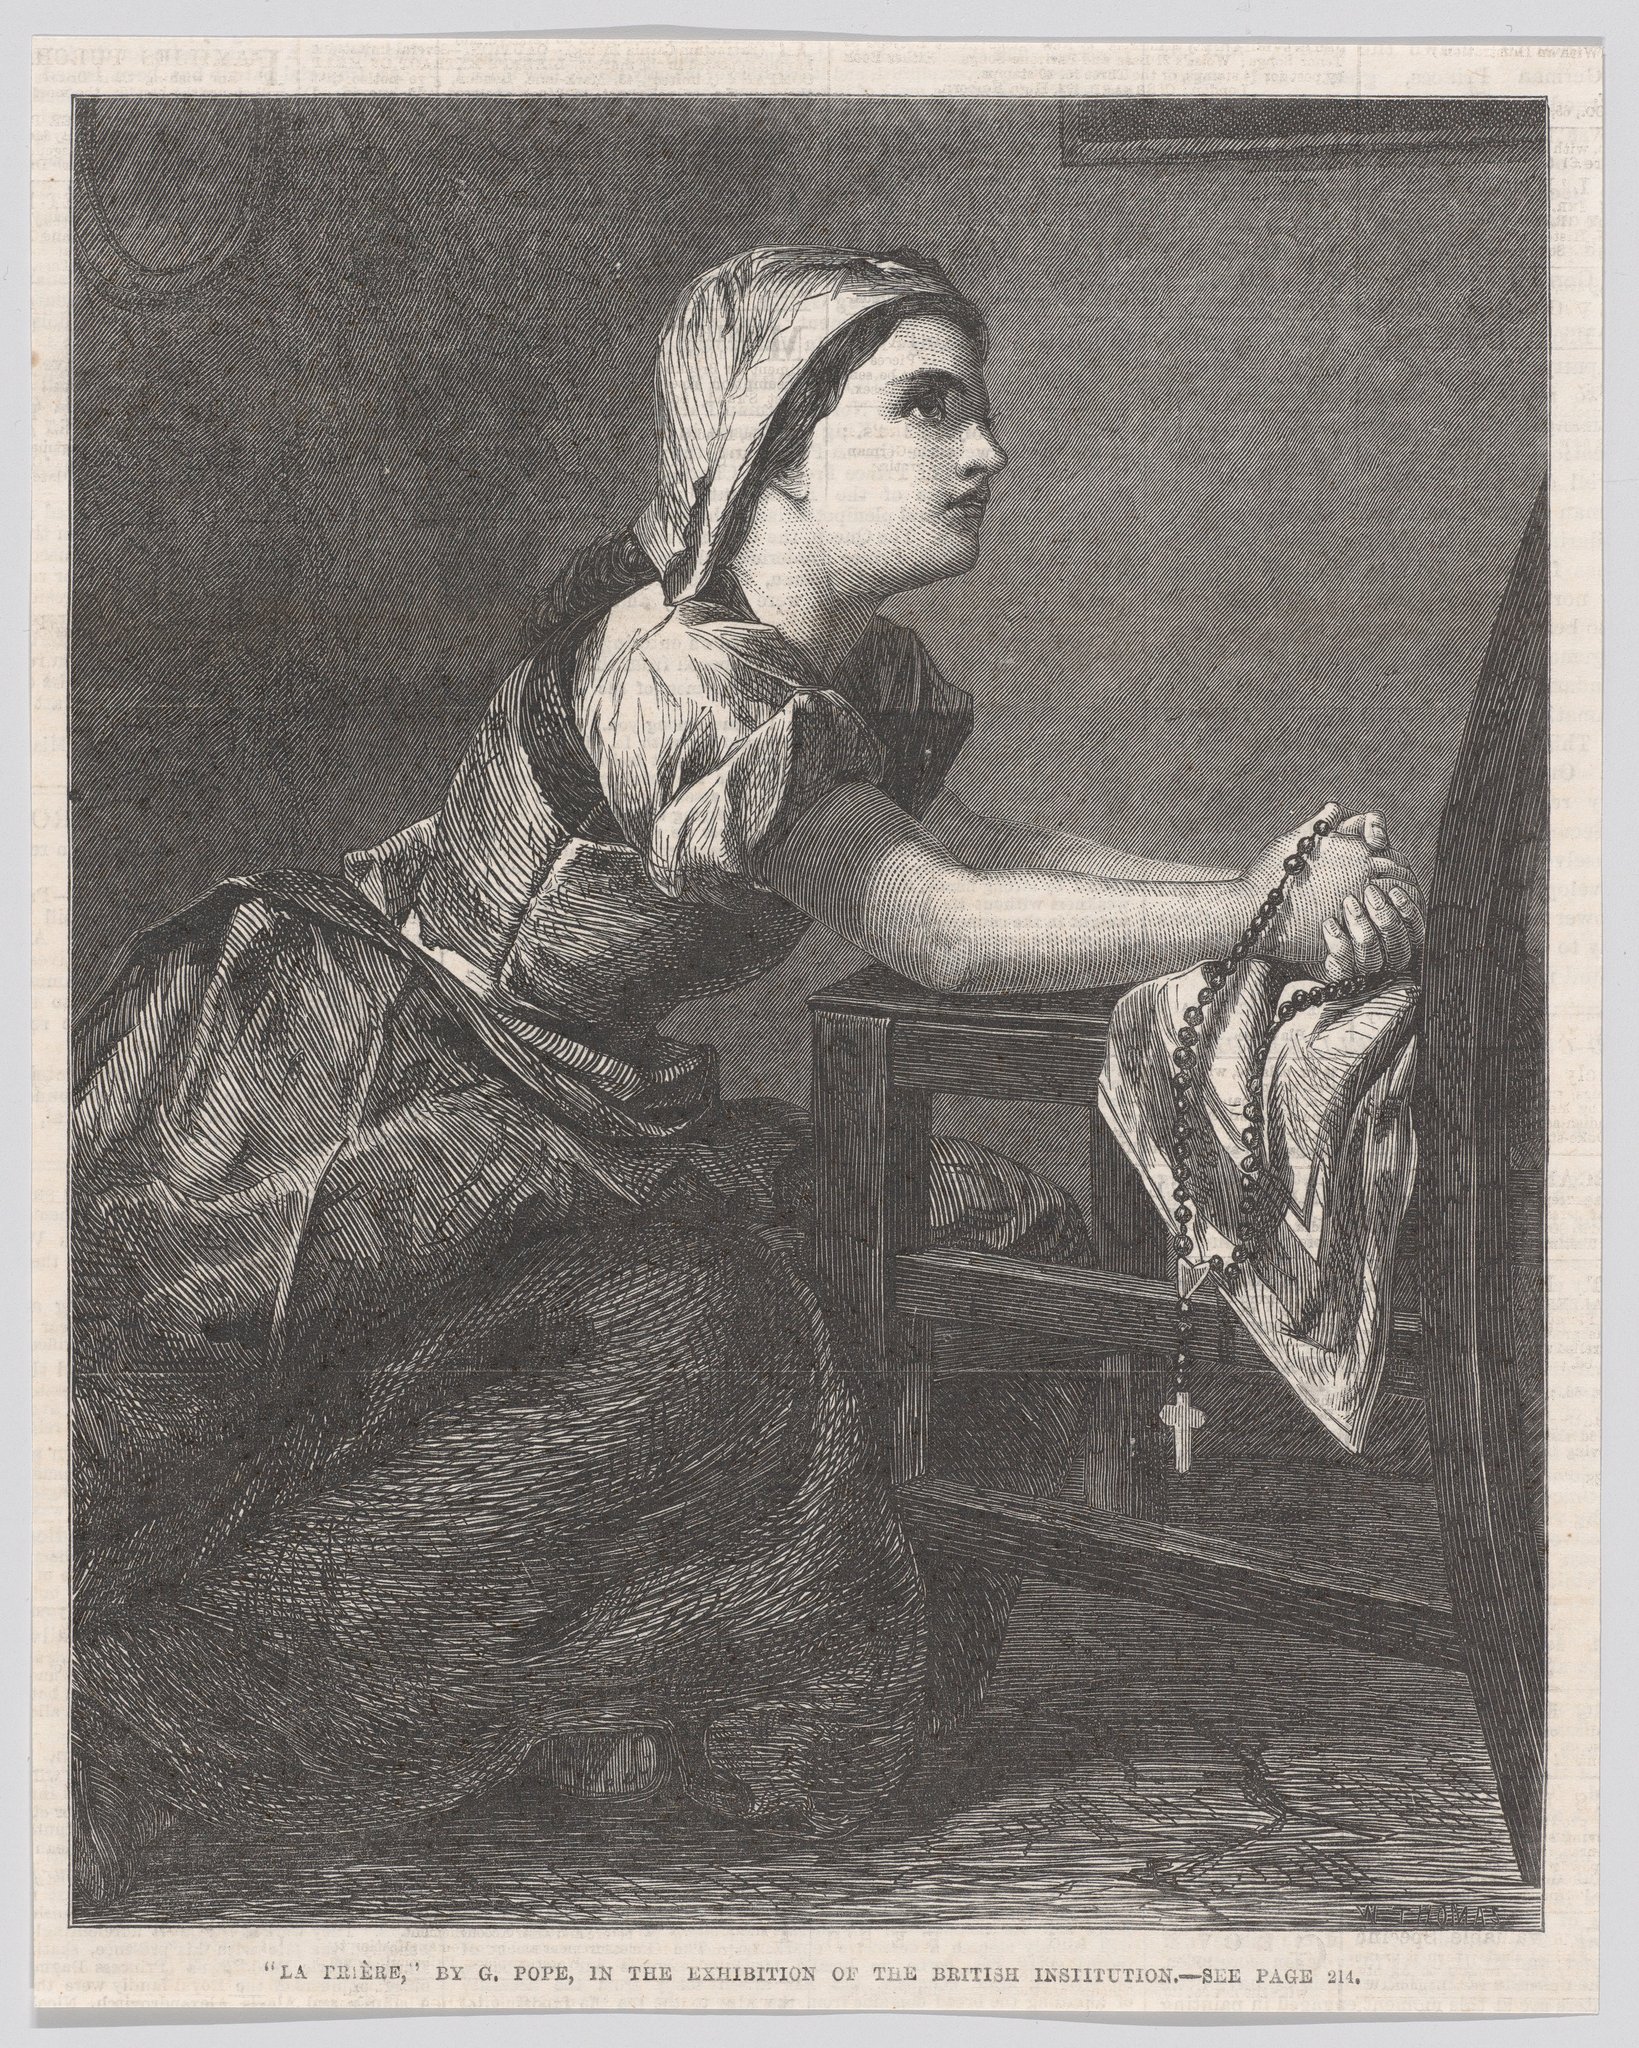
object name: print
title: La Prière (The Prayer), from "Illustrated London News"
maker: william luson thomas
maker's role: engraver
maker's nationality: british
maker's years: 1830-1900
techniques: engraving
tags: girls,rosaries